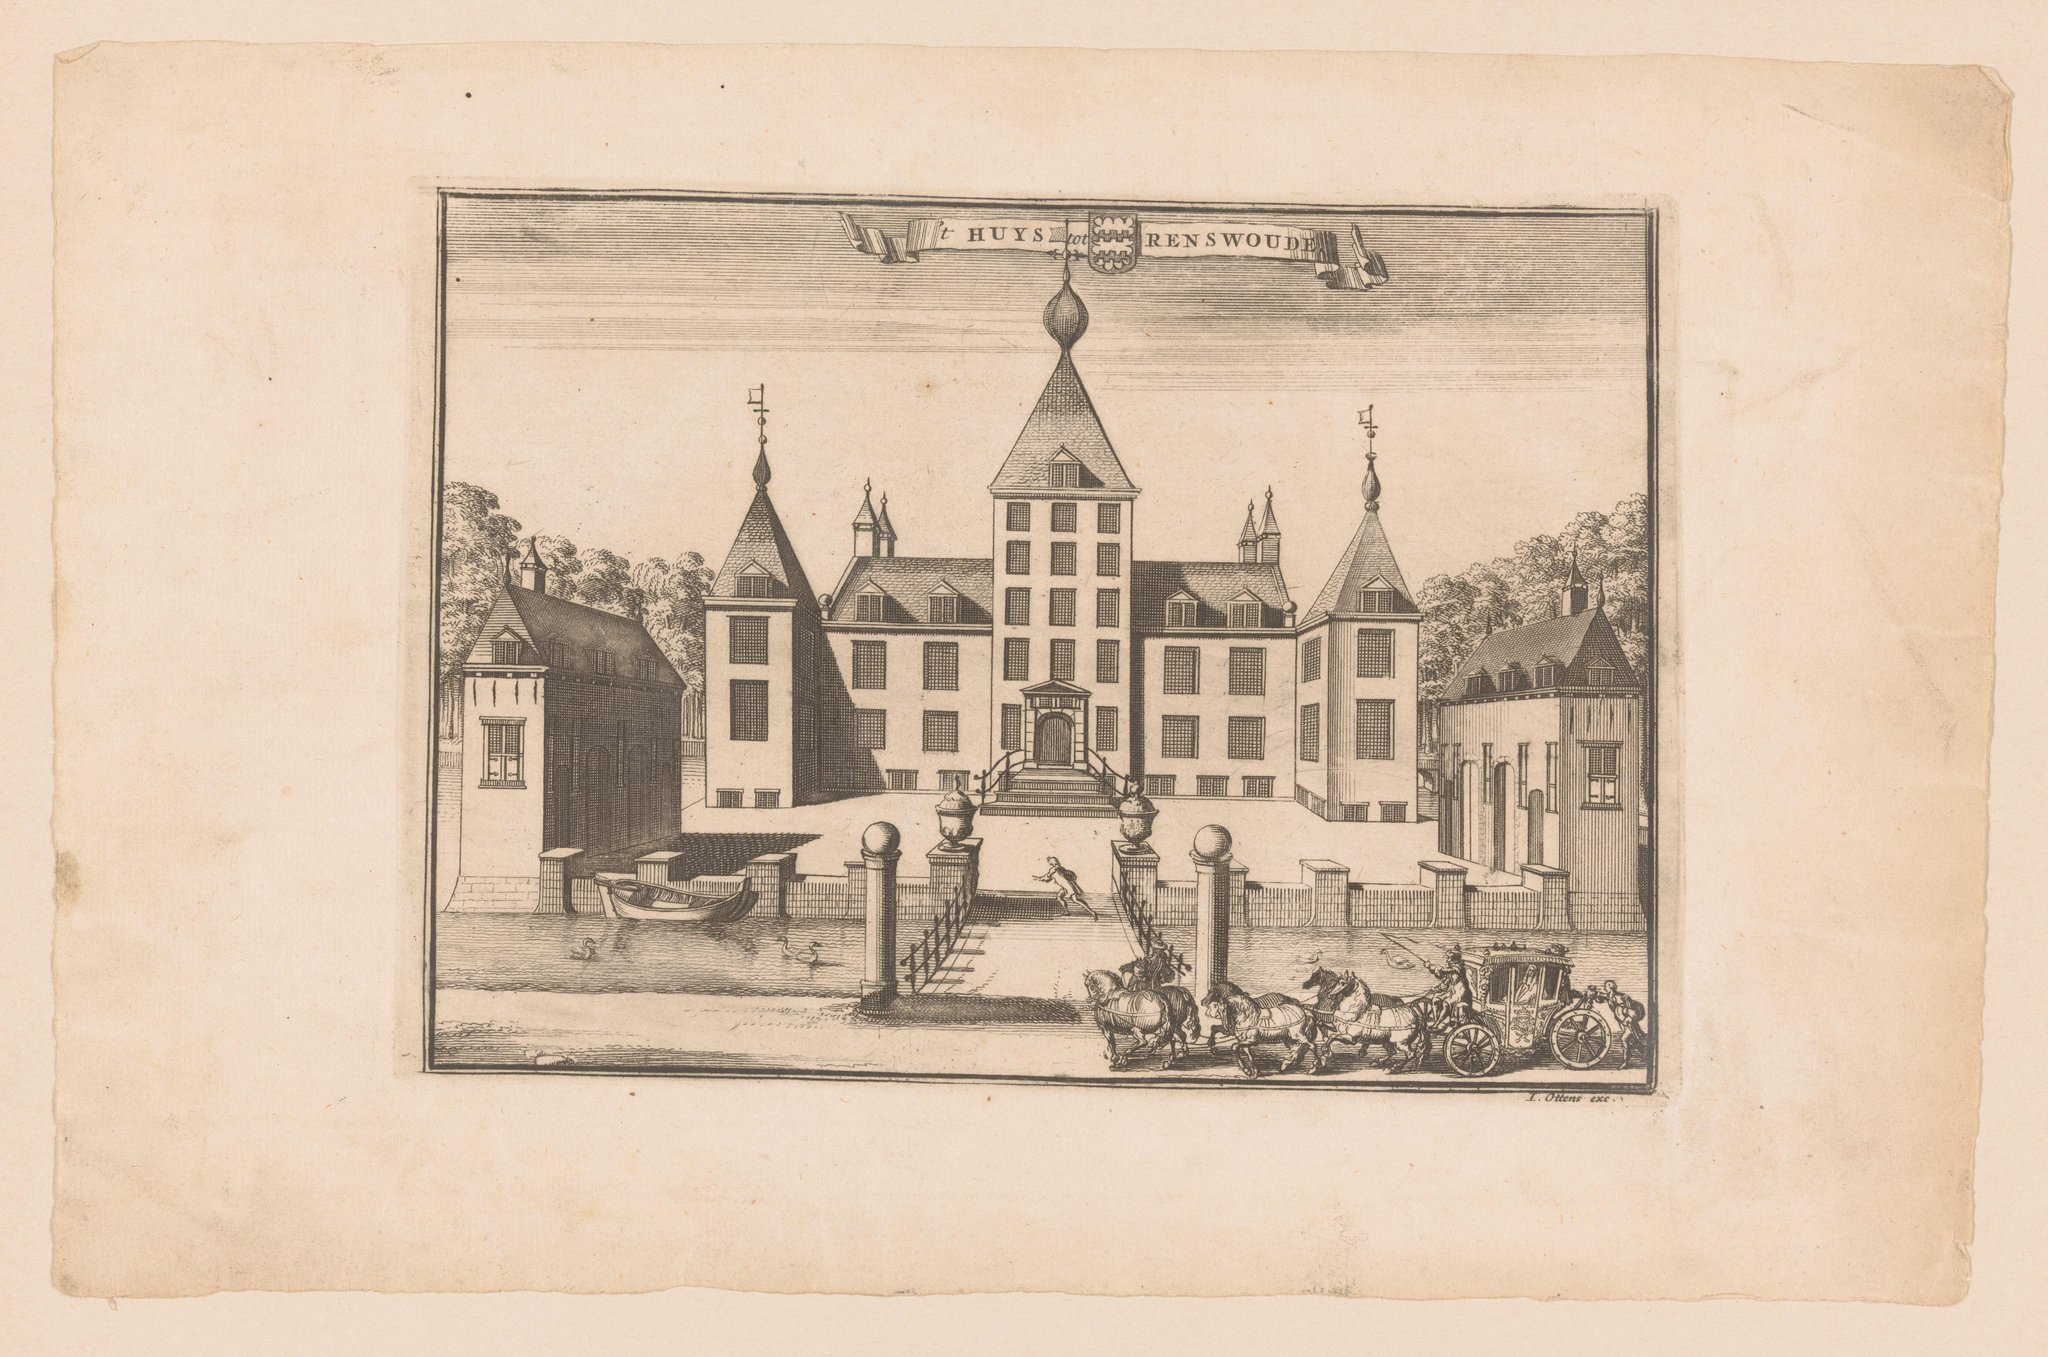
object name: book illustration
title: 't Huys tot Renswoude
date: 1710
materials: paper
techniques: engraving, etching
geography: utrecht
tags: castle, landscape with tower or castle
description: Prent uit: De Ridder-matige Huysen en Gesichten in de Provincie van Utrecht. Amsterdam: Joachim Ottens, [ca. 1710].